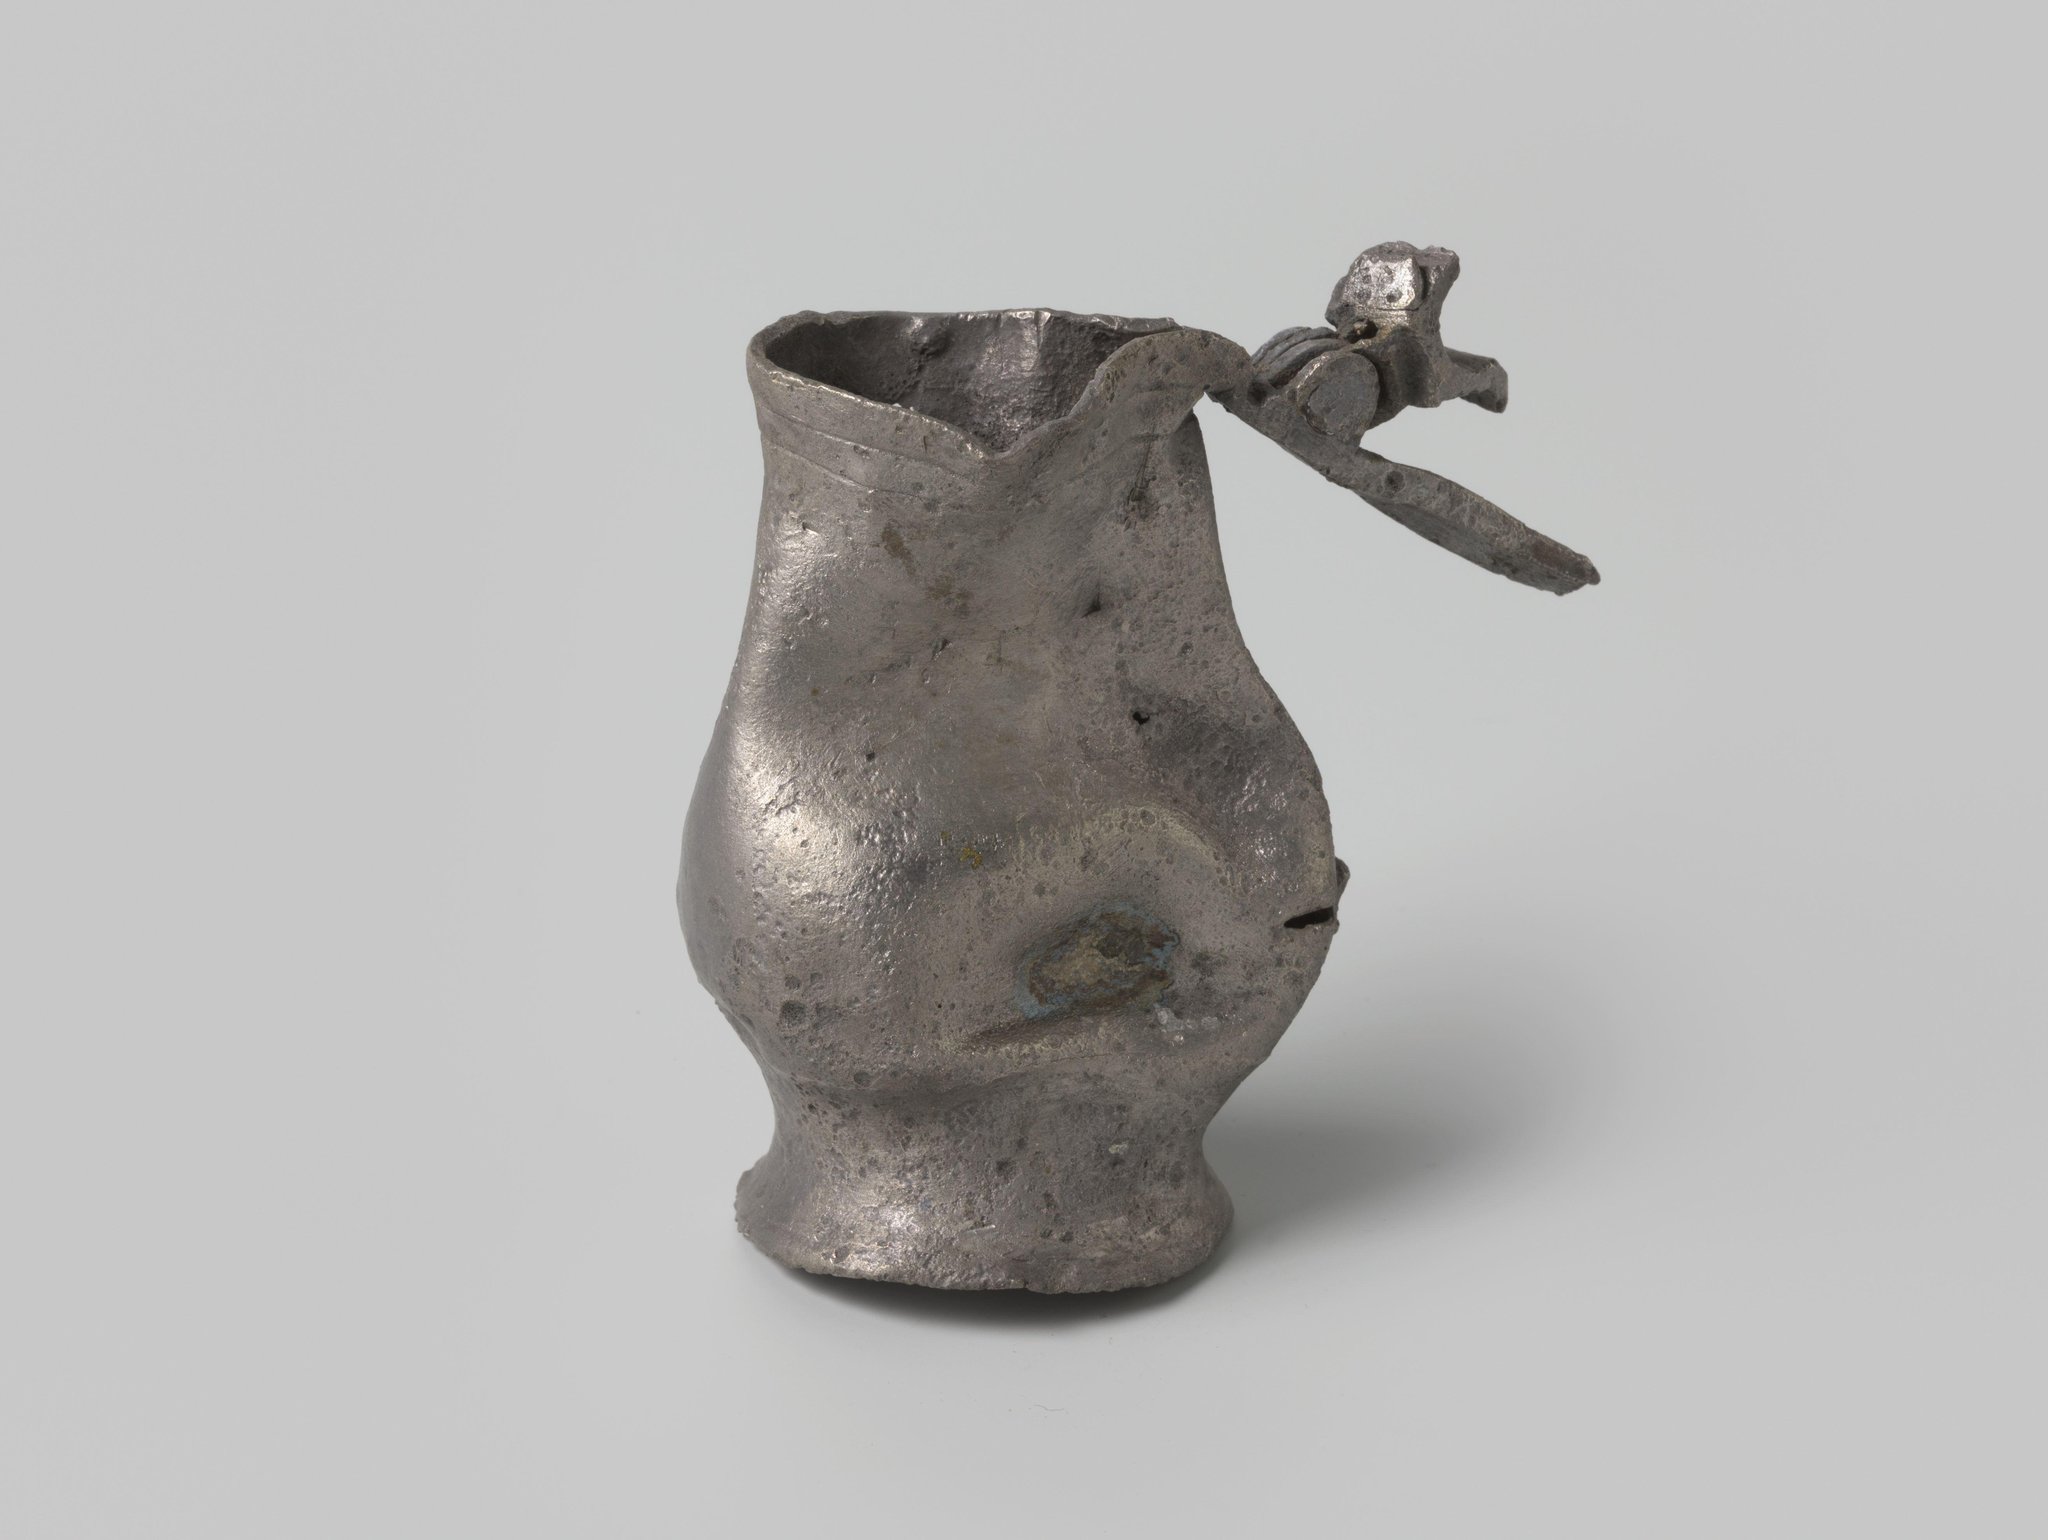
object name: ewer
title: Kannetje uit het wrak van de Oost-Indiëvaarder Hollandia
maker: Anonymous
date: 1700-1743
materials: tin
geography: netherlands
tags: verenigde oostindische compagnie, hollandia (schip), annet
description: Jug; identical to NG-1976-10-H-66, lid and handle-terminal missing.